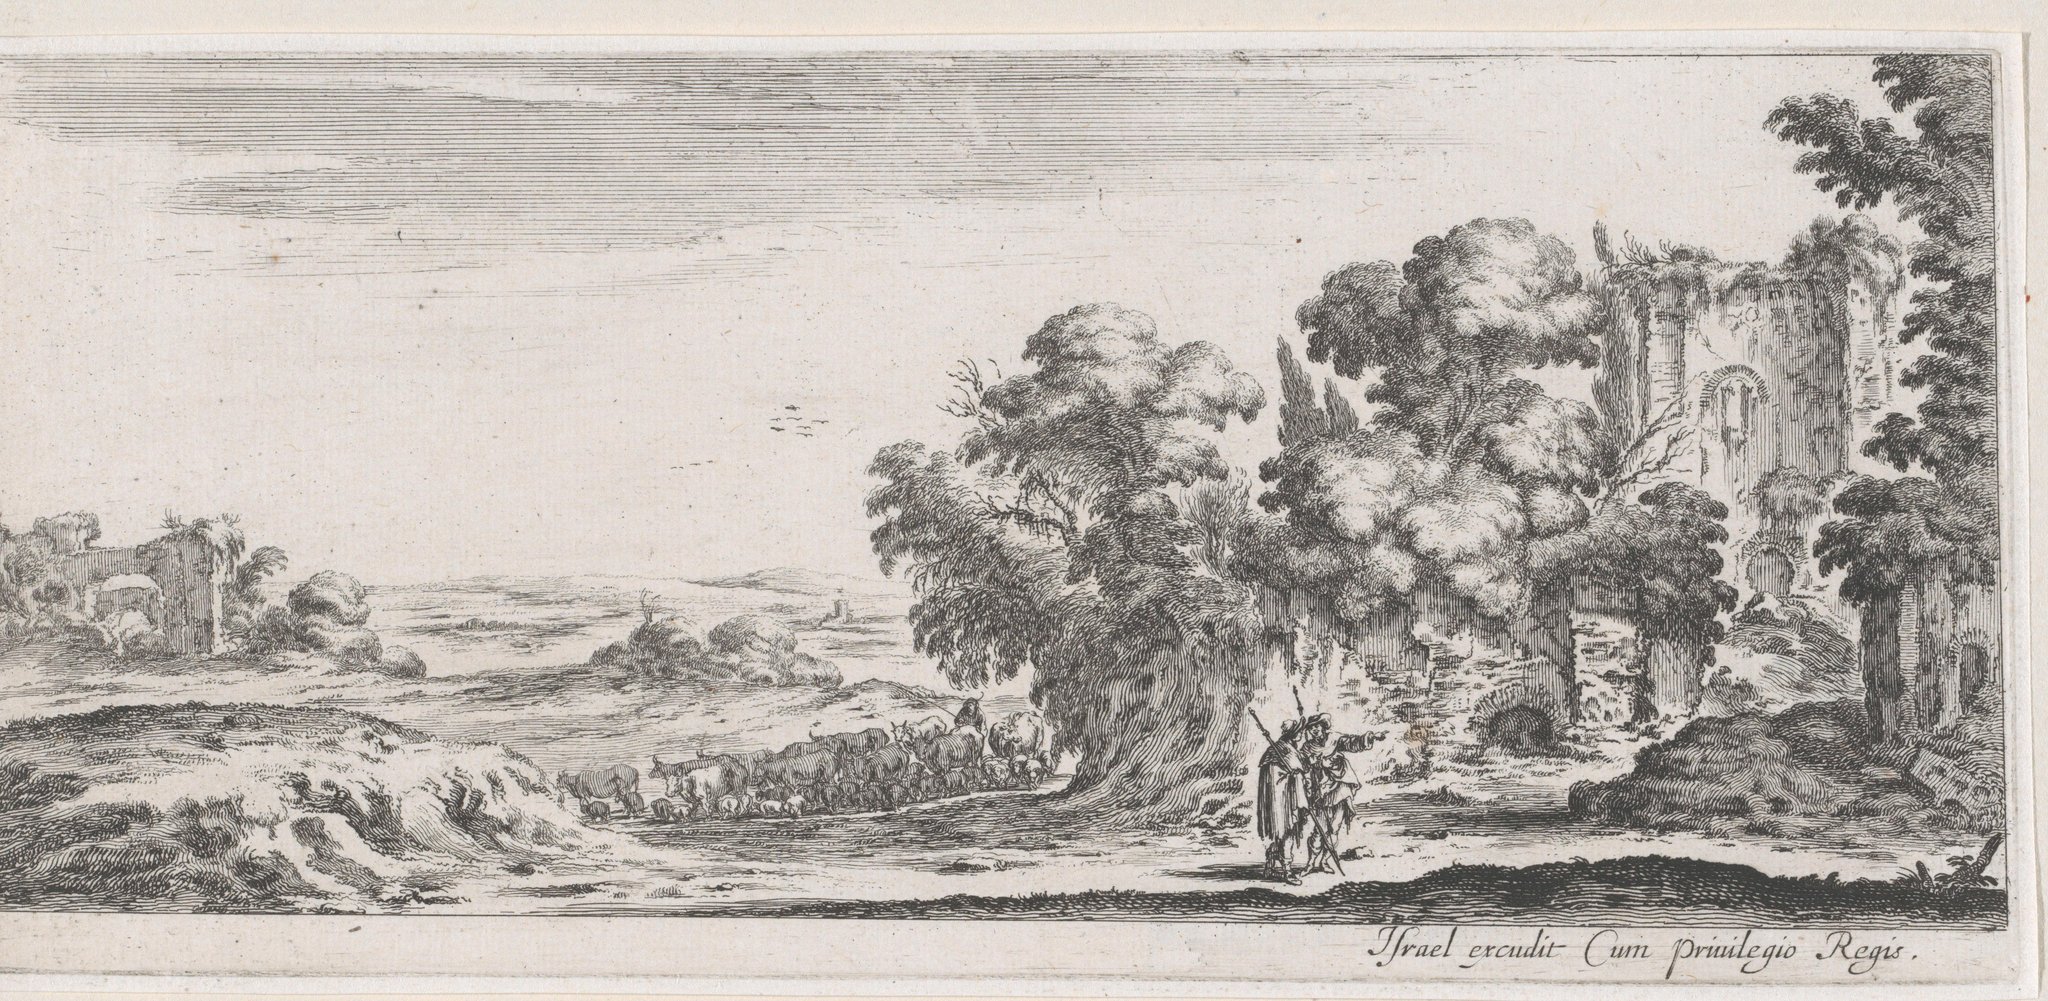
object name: print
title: Twee pelgrims bij ruïne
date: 1620-1664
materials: paper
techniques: etching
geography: paris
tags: herding, herdsman, herdswoman, shepherd, shepherdess, cowherd, etc., pilgrim(s), landscape with ruins, herd, flock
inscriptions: collector's mark: Lugt 240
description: Een landschap met twee pelgrims bij een ruïne. Op de achtergrond een herder met een kudde runderen en schapen.